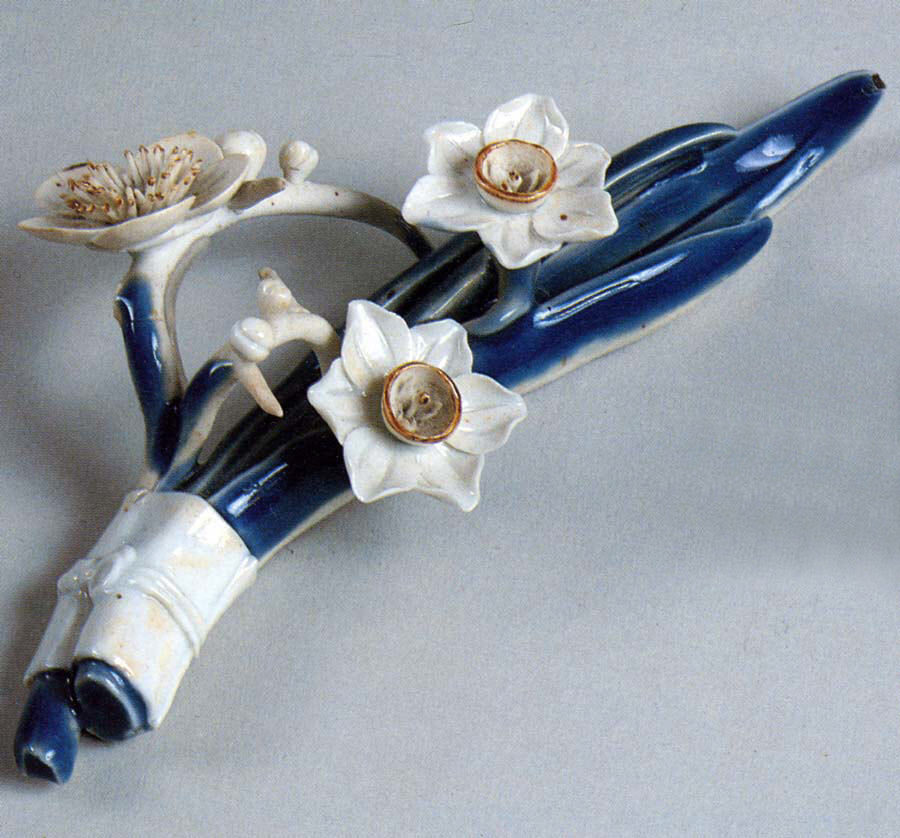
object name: brush rest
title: Brush Rest (Fude-oki) in the Shape of a Narcissus Spray and Blossoming Plum Branch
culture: japanese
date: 1801-1850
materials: cobalt, glaze, porcelain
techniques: molding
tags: narcissus